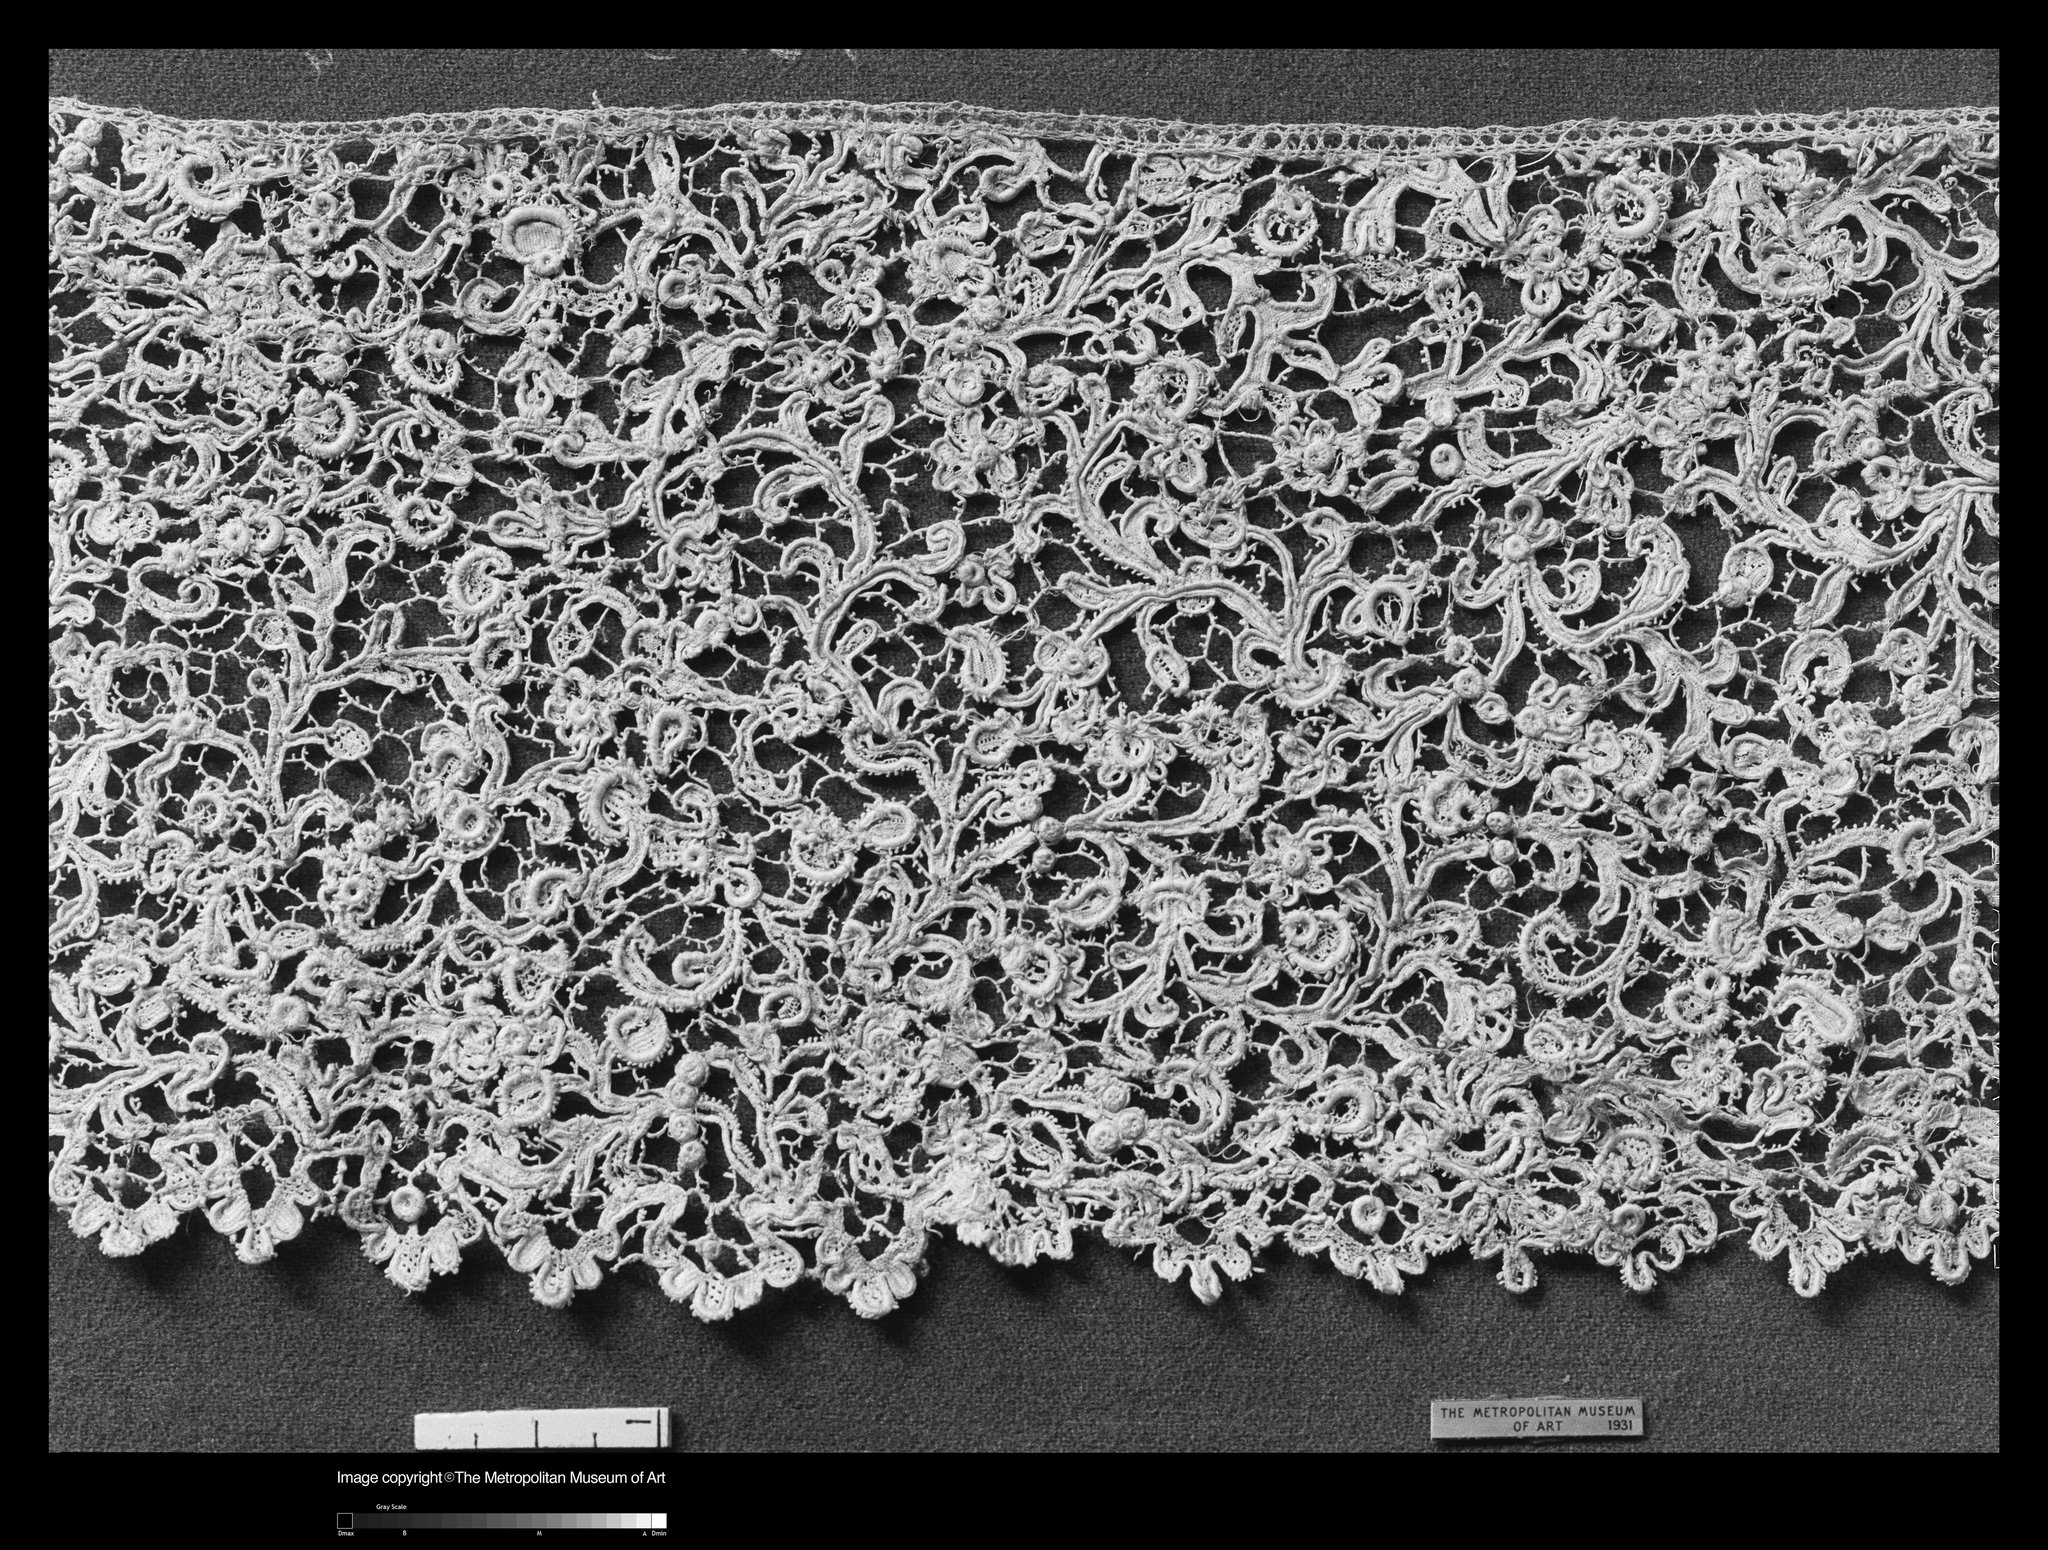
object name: border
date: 1601-1700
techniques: lace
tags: flowers